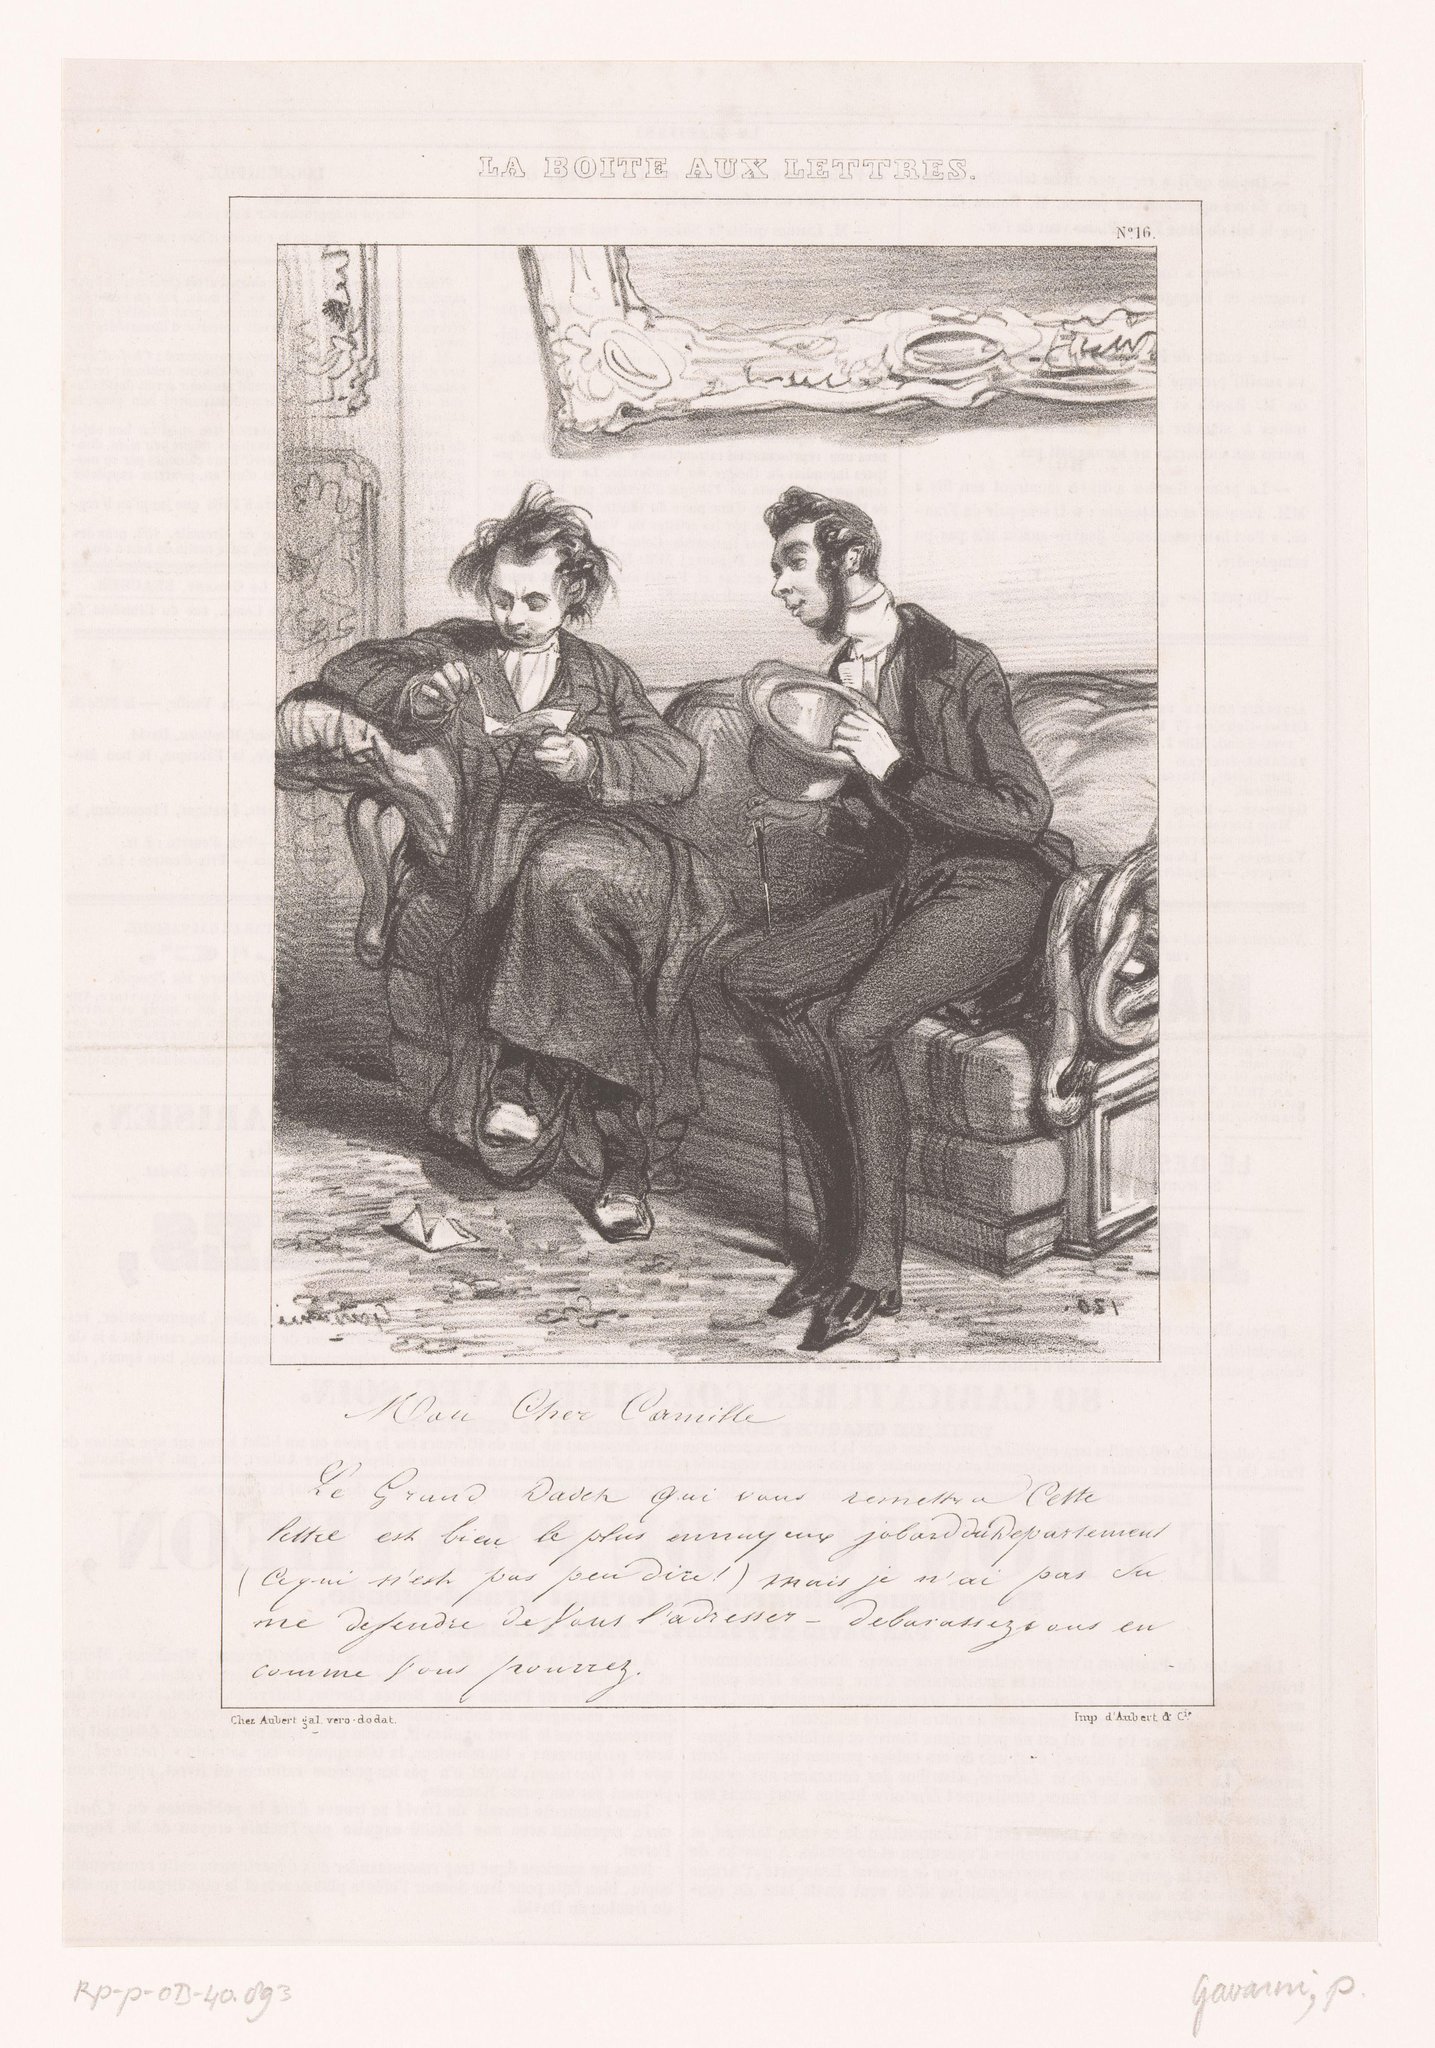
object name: print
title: Brieven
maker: paul gavarni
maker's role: draughtsman, print maker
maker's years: 1804-1866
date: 1838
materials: paper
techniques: lithograph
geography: paris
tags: sitting figure, letter, envelope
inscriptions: collector's mark: Lugt 2228a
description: De brief spot met degene die de brief heeft overhandigd, en die links naast de brieflezer zit.